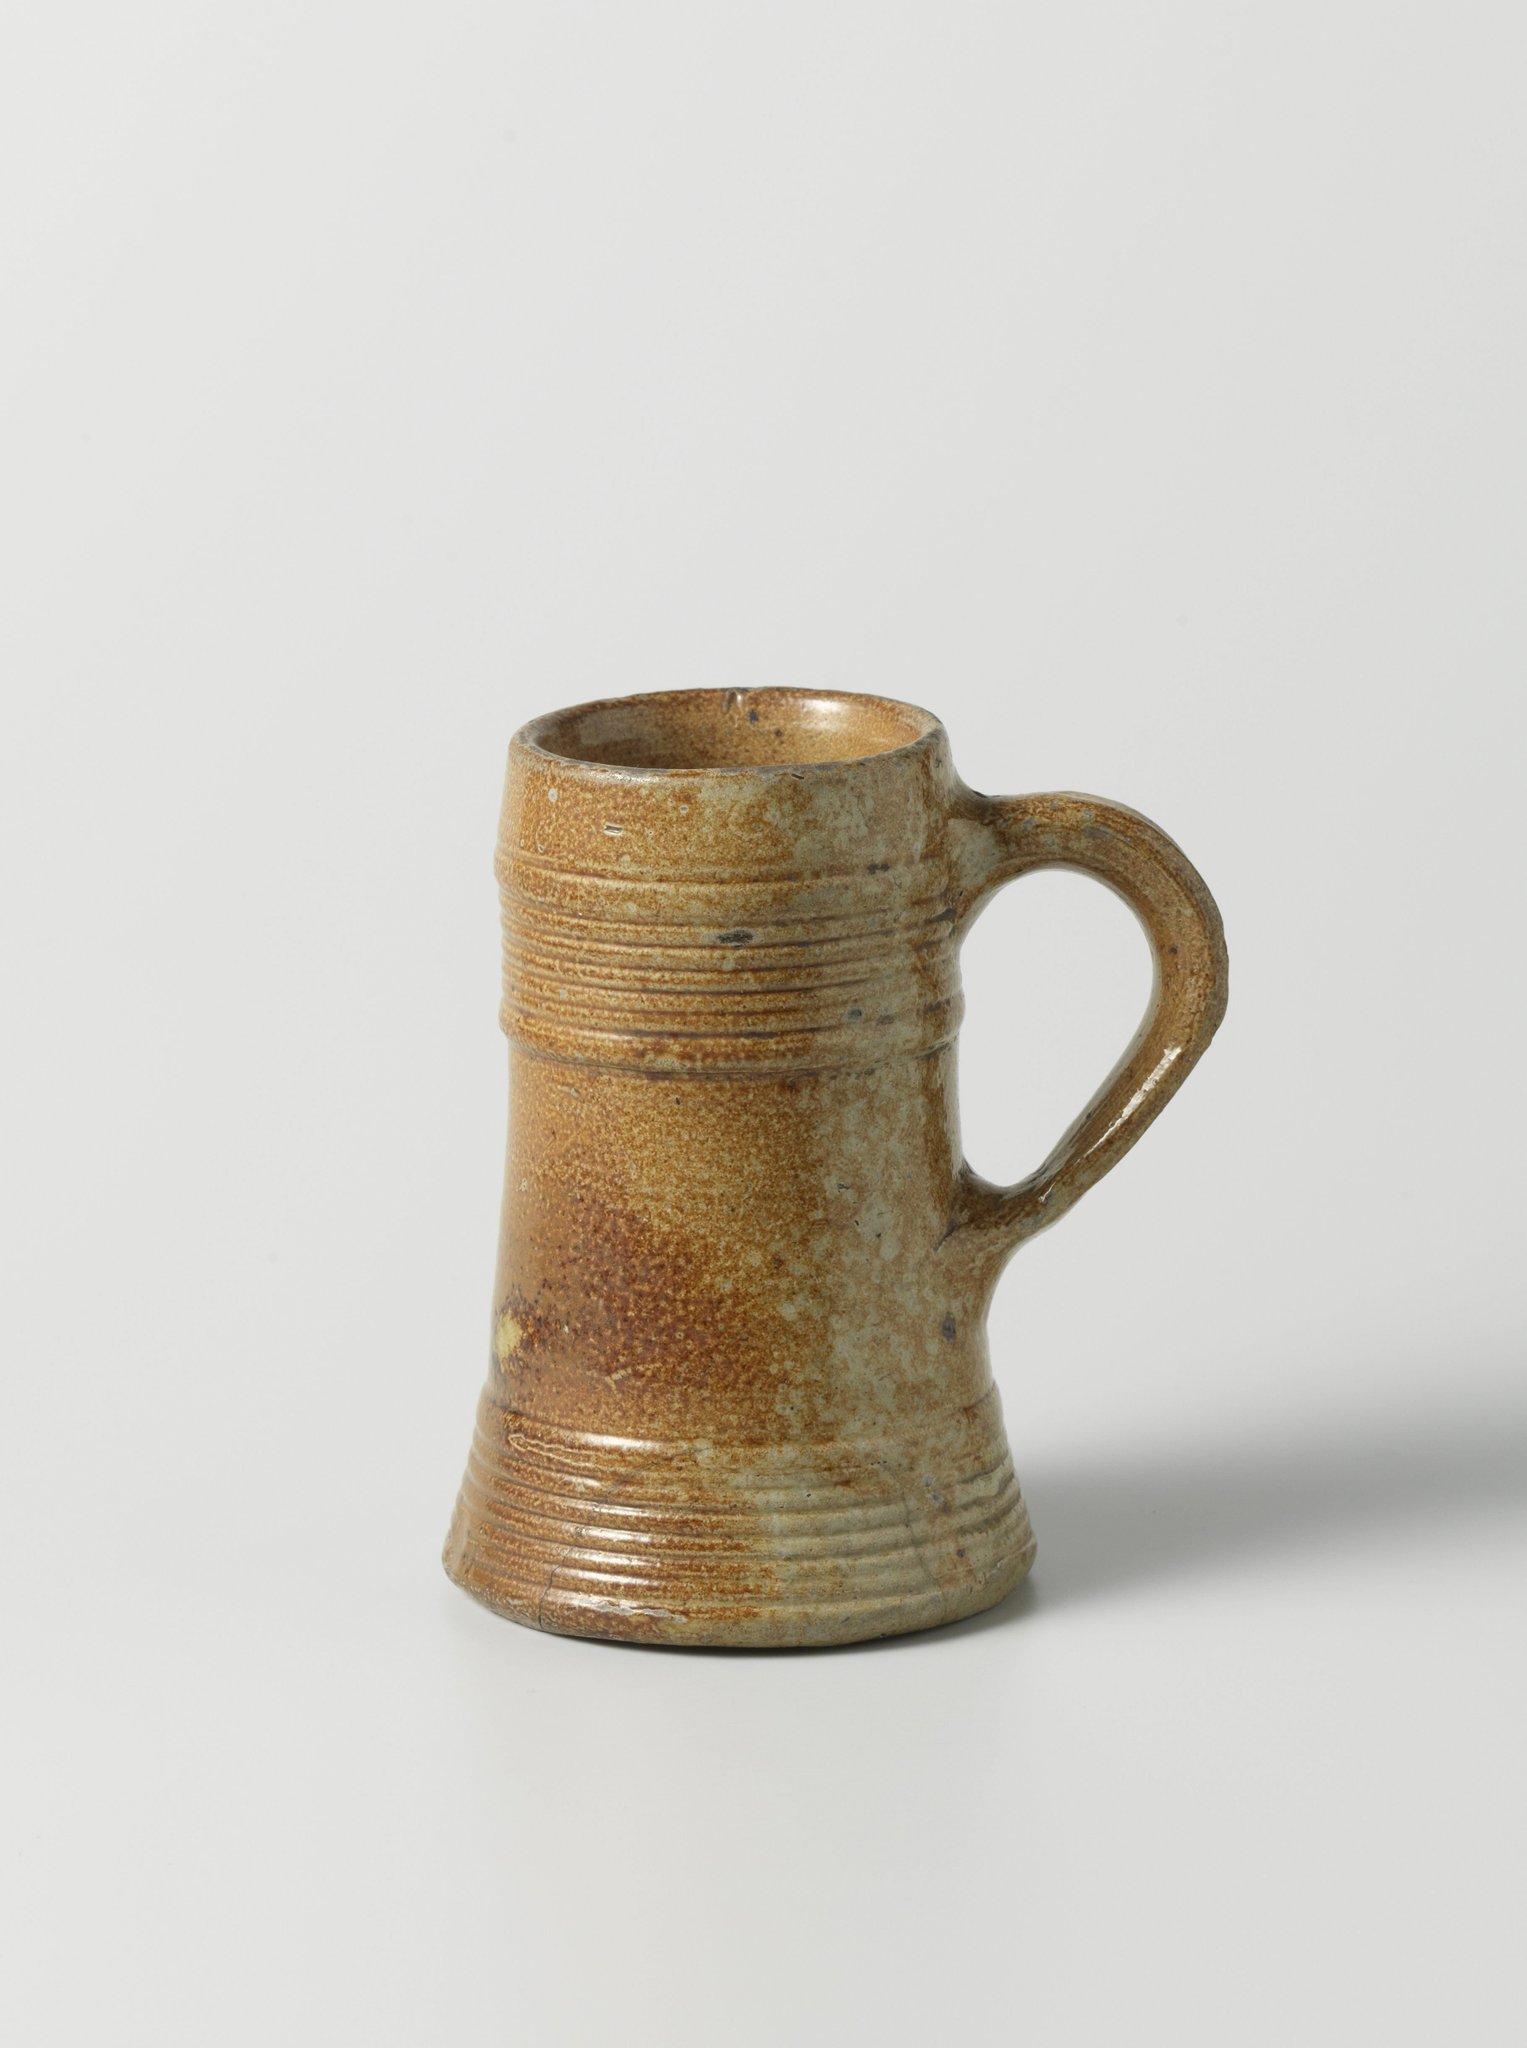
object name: cup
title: Ribbed tankard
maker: Anonymous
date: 1560-1580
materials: engobe, glaze, stoneware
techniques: firing, forming, relief, turning, vitrification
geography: raeren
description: Bierpul van steengoed met een cilindrisch, naar onder toe spreidend lichaam en C-vormig oor. Bedekt met een bruine engobe. Onder de rand en boven de voet een brede, geribde band. Raeren.